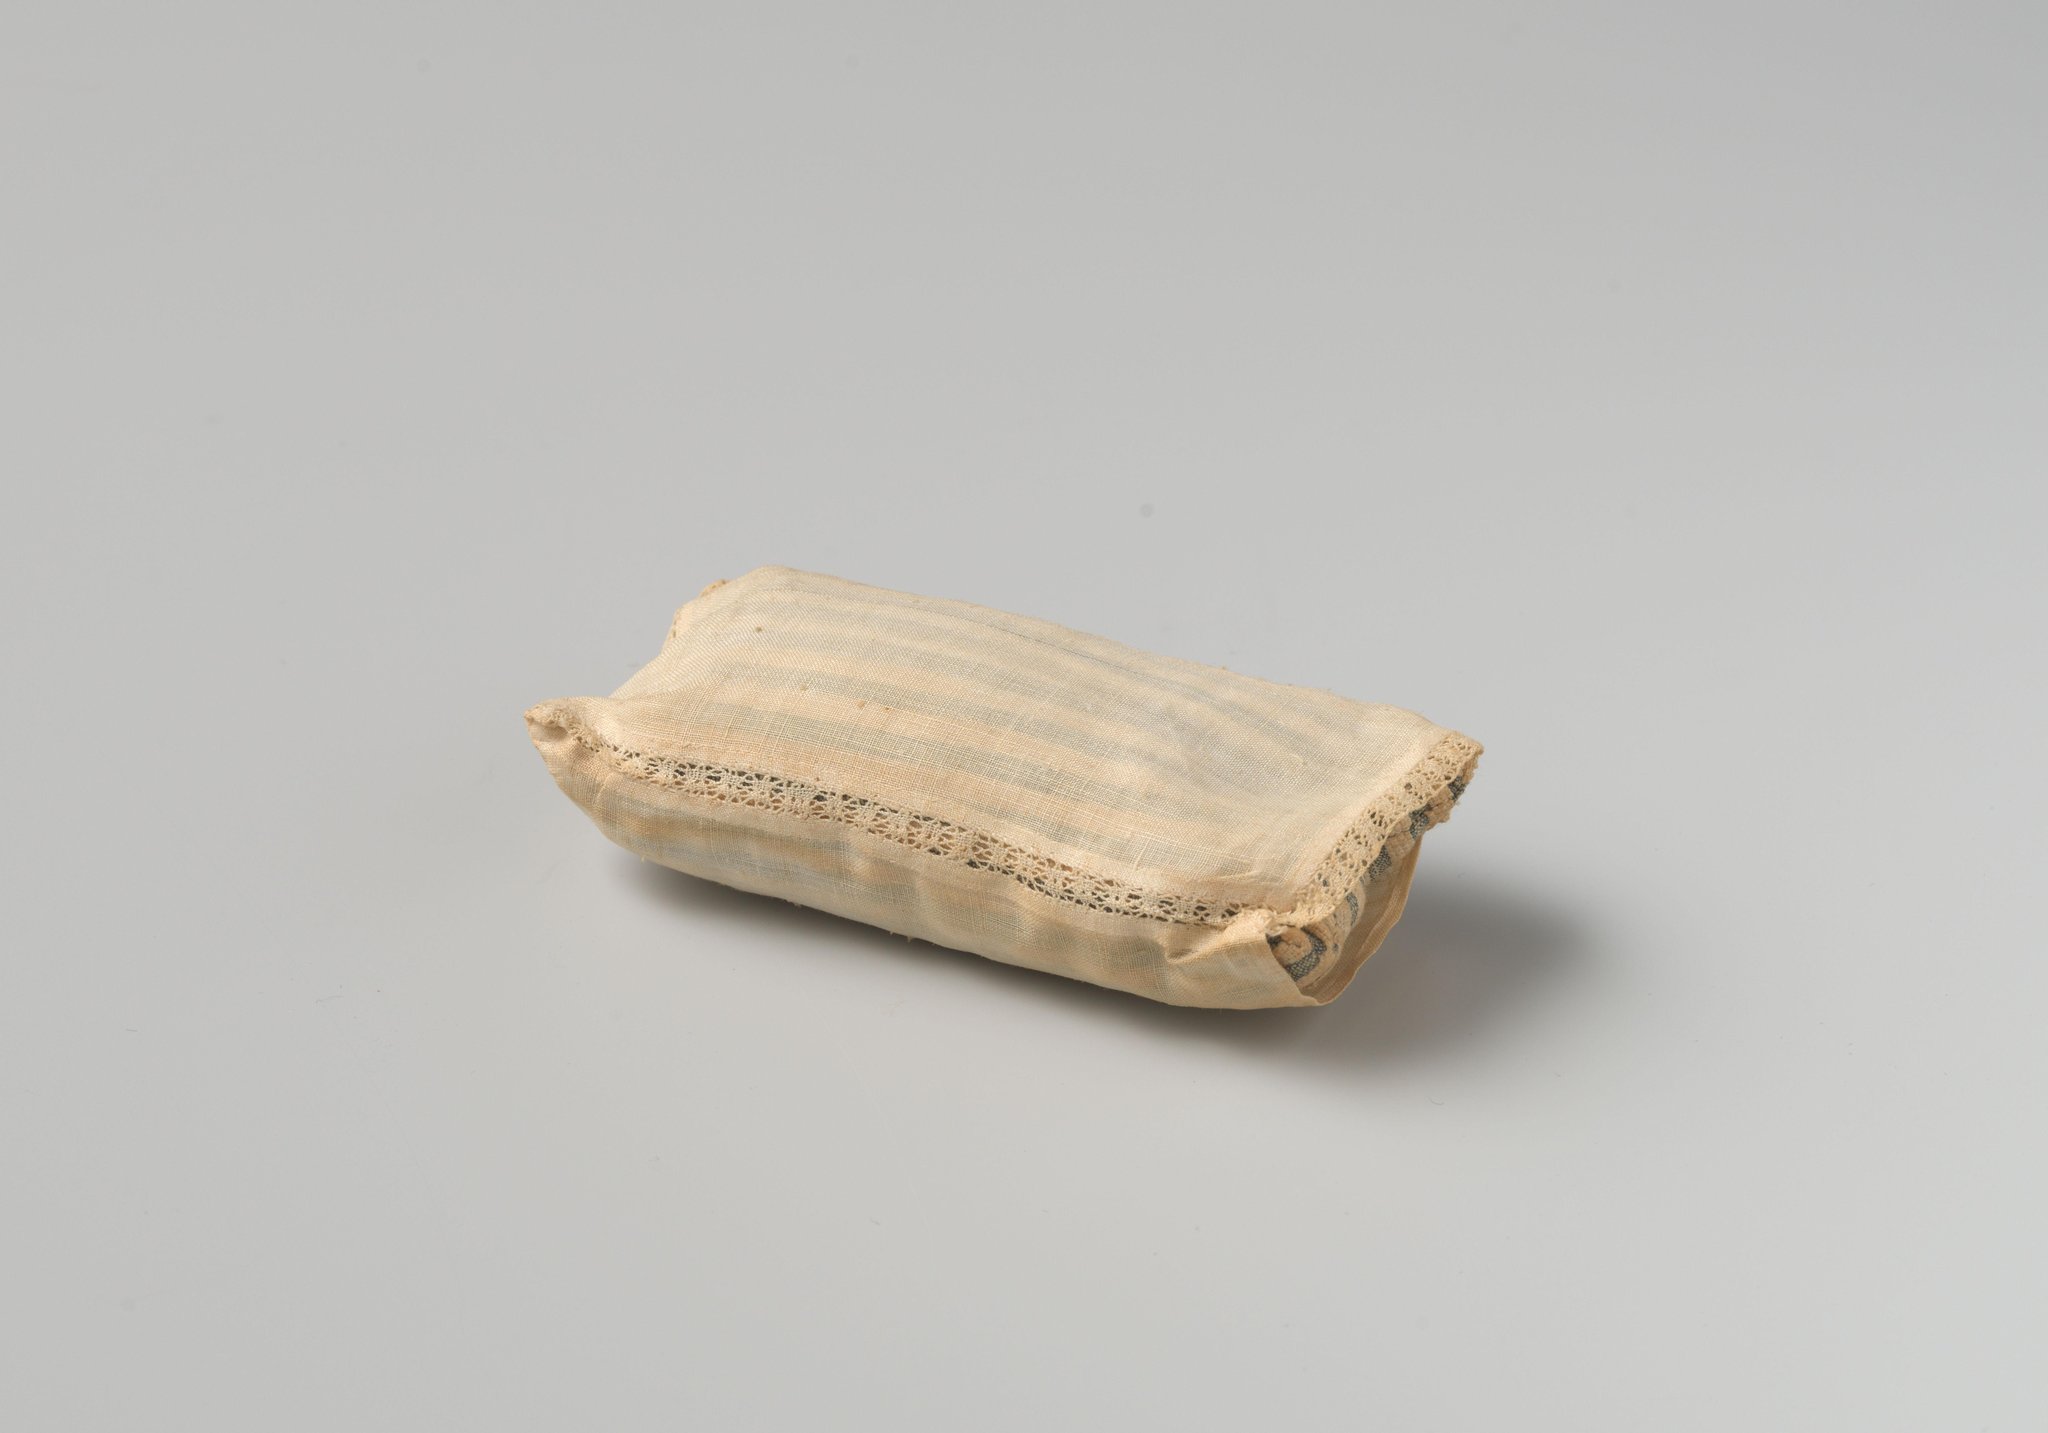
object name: miniature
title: Sloop voor matras van zeer fijn wit linnen (batist), rondom met tussenzetsel van kloskant aan zoom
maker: Anonymous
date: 1690-1710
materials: linen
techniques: lace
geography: amsterdam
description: Sloop voor matras van zeer fijn wit linnen (batist), rondom met tussenzetsel van kloskant aan zoom (oorspronkelijk dichtgenaaid).